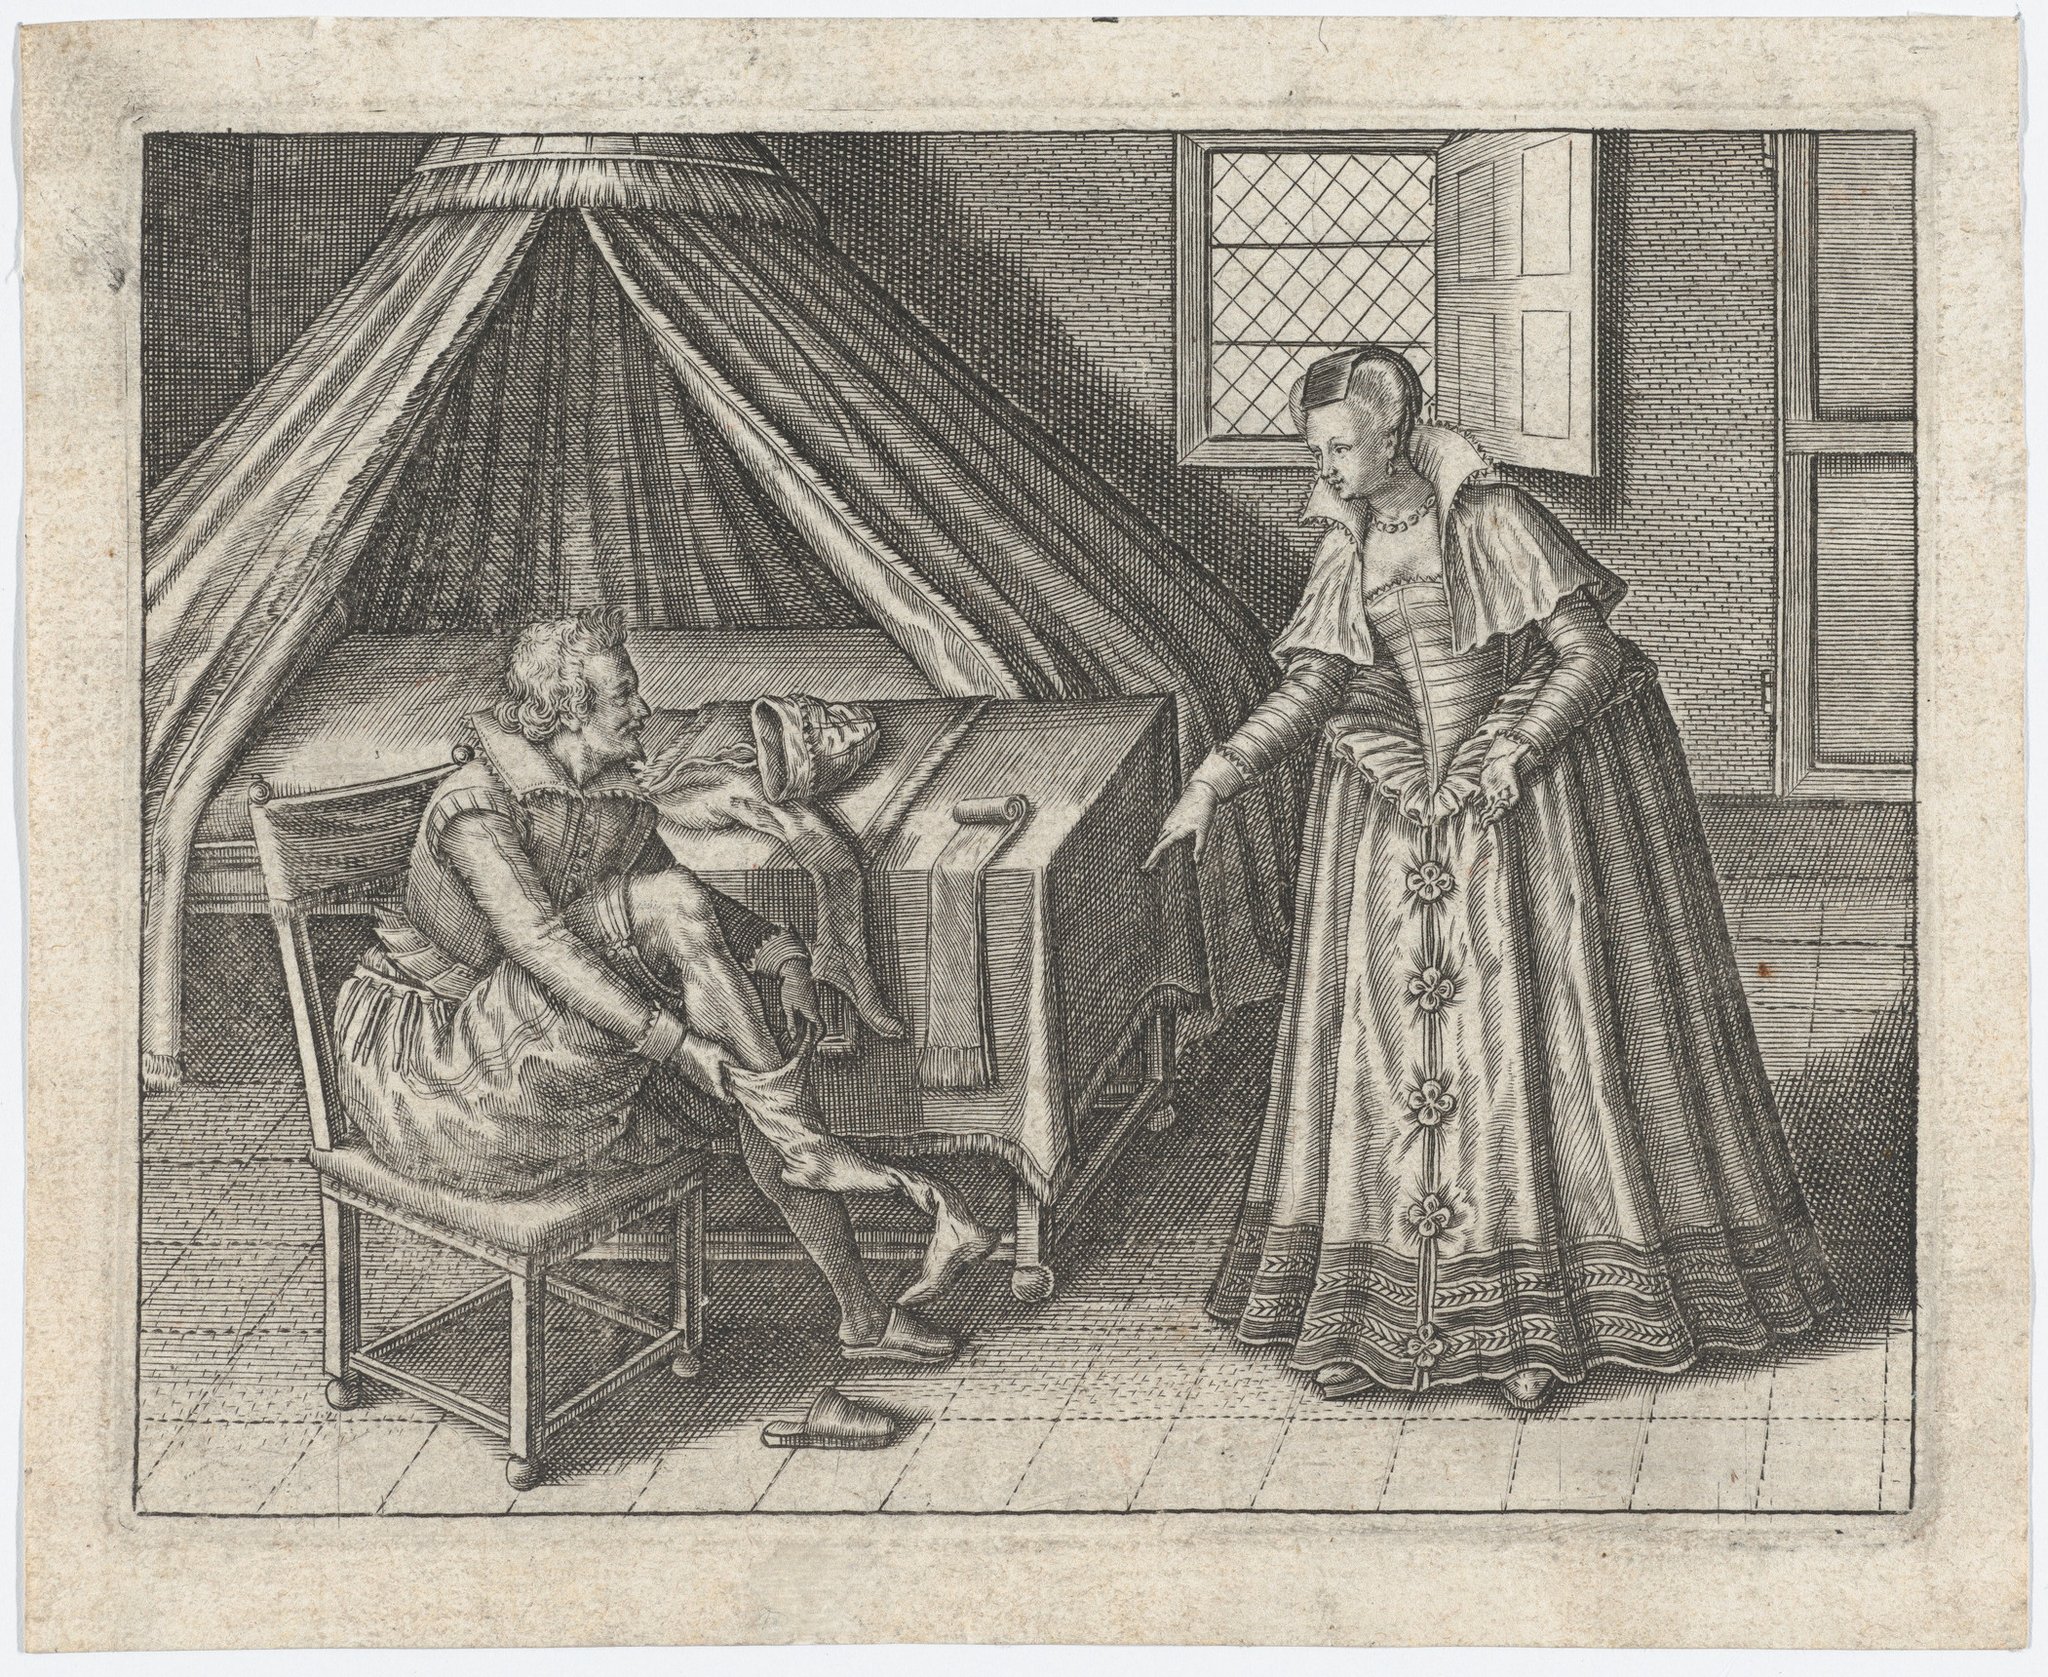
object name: print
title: Enigmes Joyeuses pour les Bons Esprits, Plate 2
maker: jan van haelbeeck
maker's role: artist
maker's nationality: flemish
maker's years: 1595-1635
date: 1615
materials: copper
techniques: engraving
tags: bedrooms,men,women,dressing